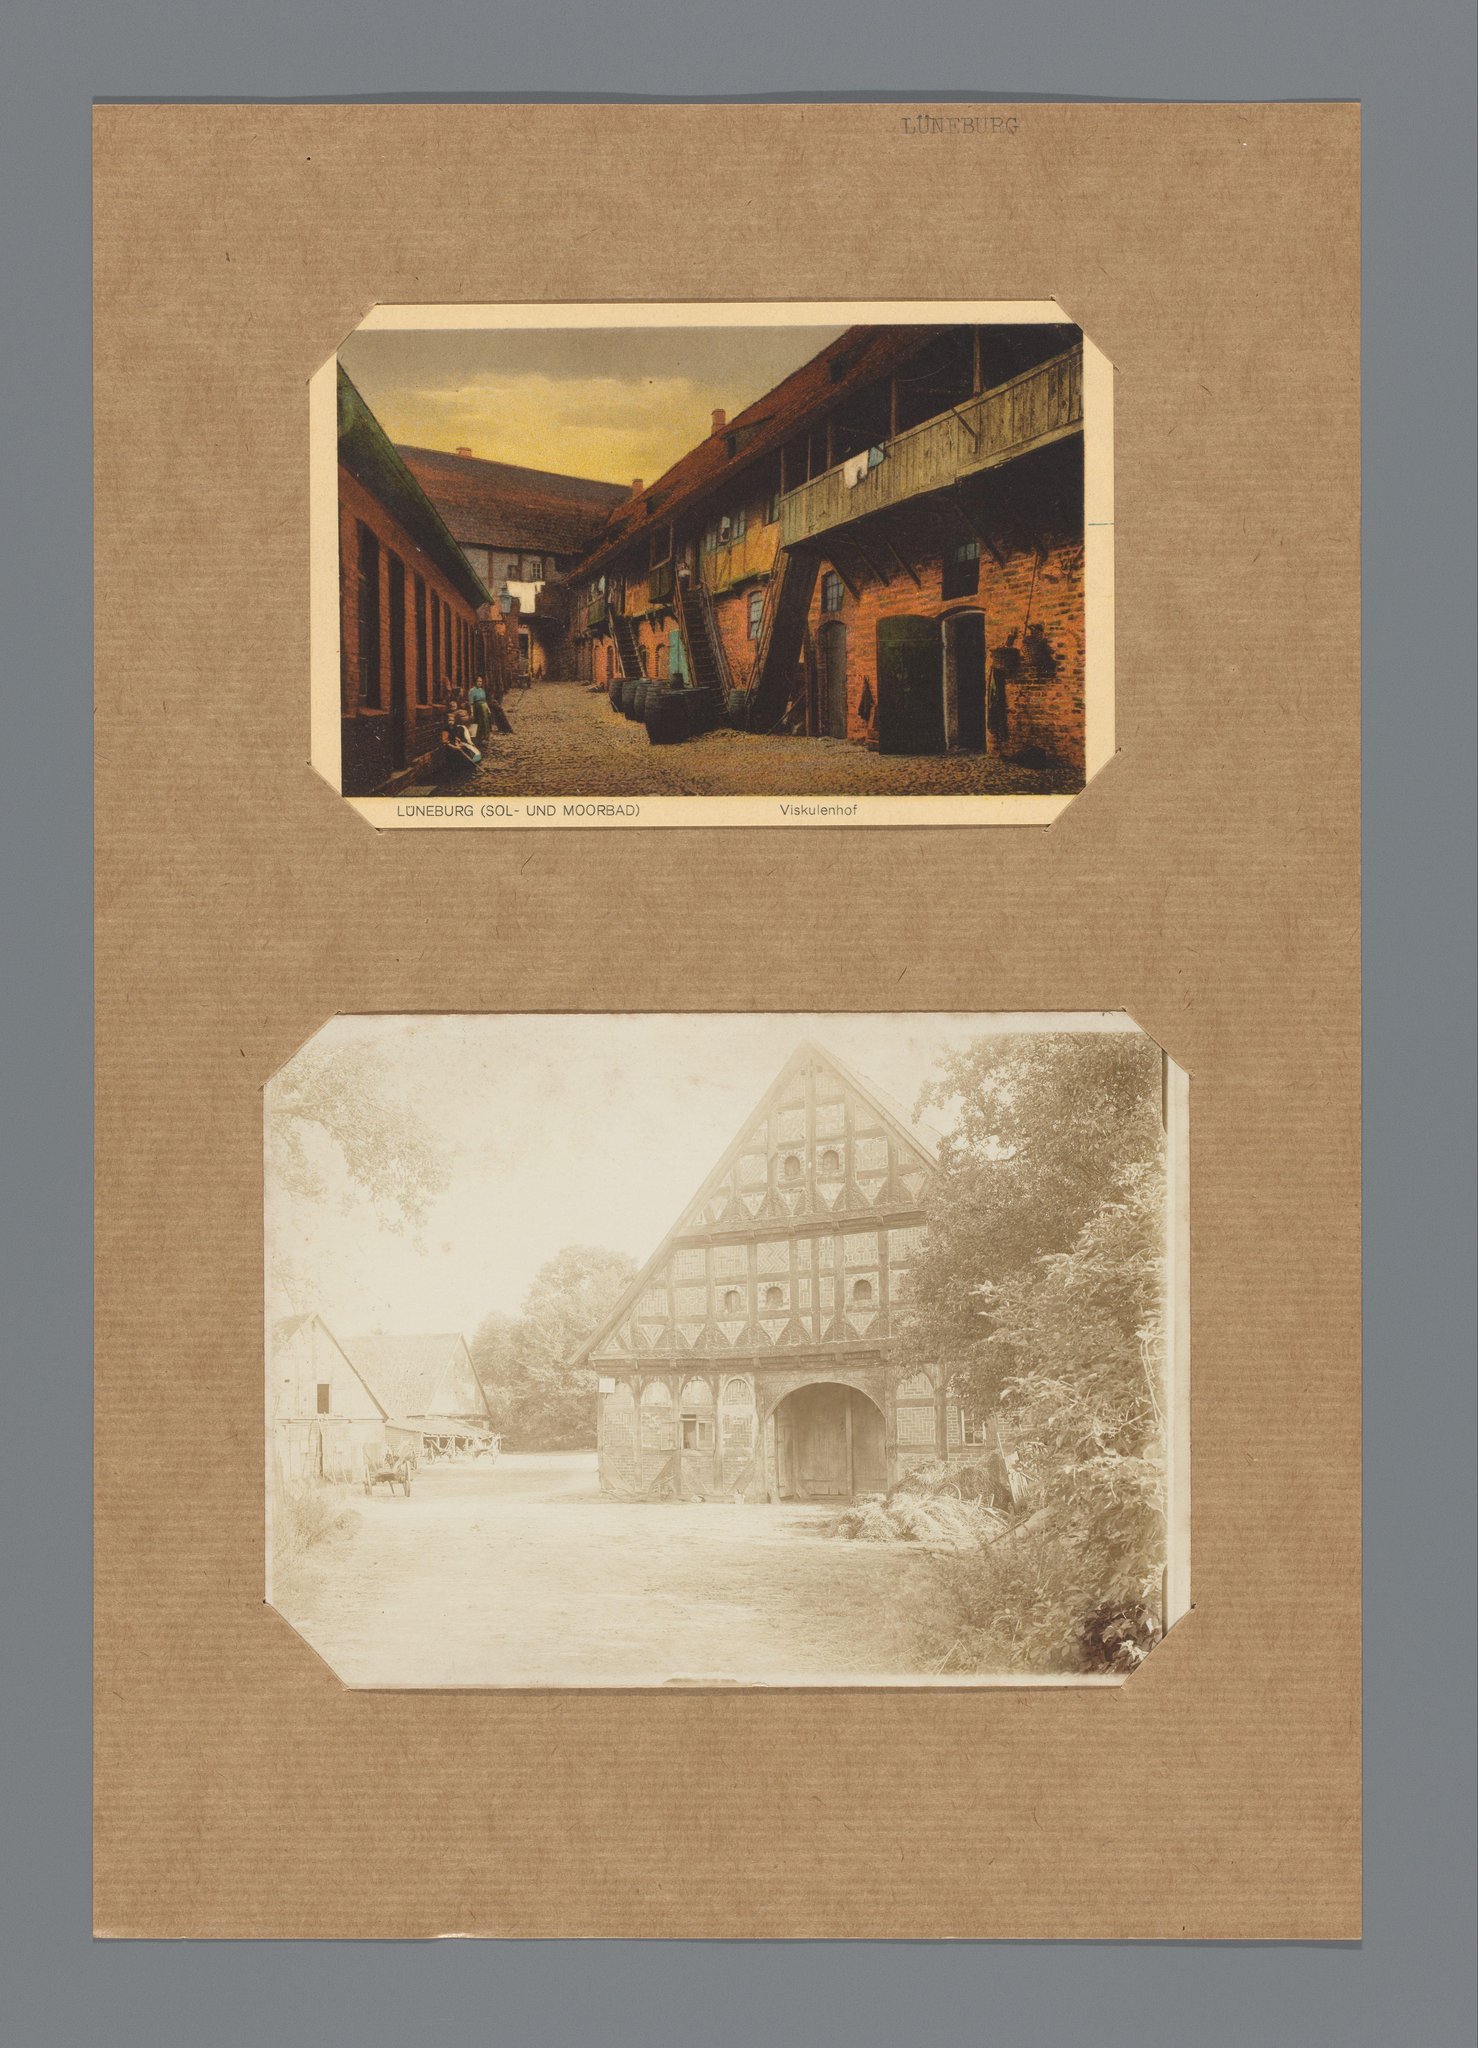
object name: photograph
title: Duitsland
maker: Anonymous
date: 1880-1920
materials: photographic support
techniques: photograph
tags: germany